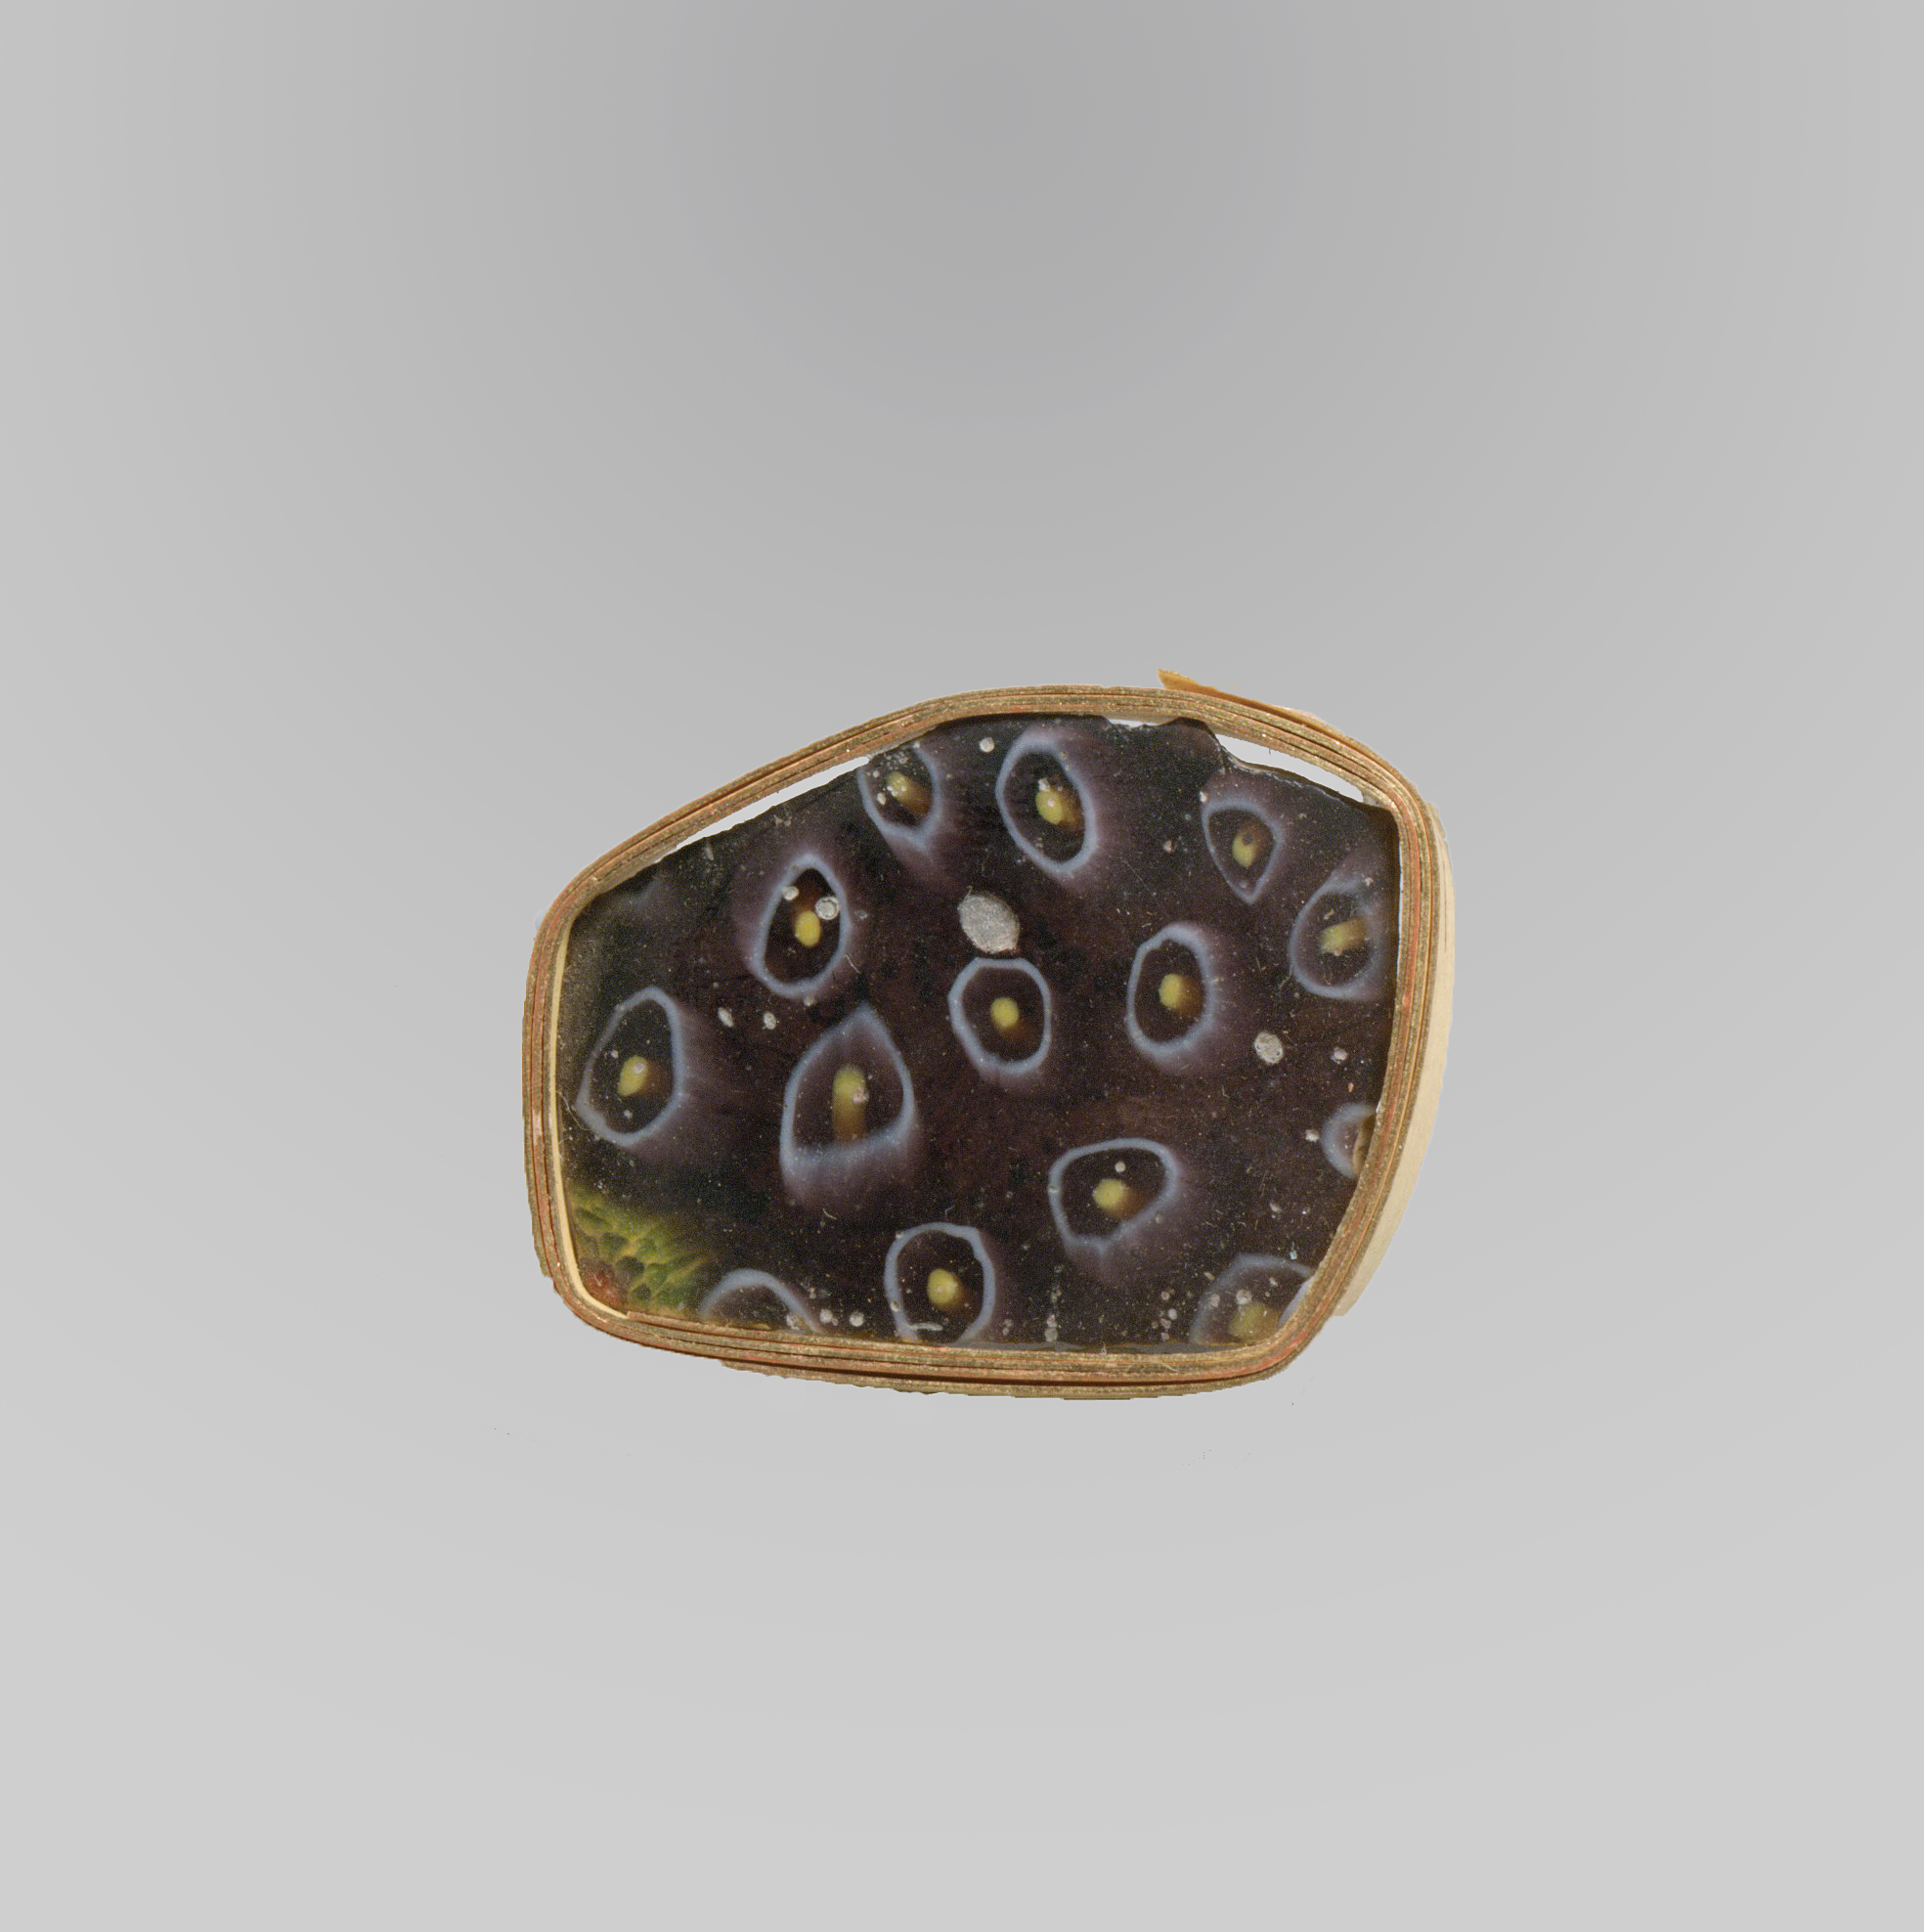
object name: fragment, mosaic glass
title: Glass mosaic fragment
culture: roman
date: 34 BCE-33 CE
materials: glass